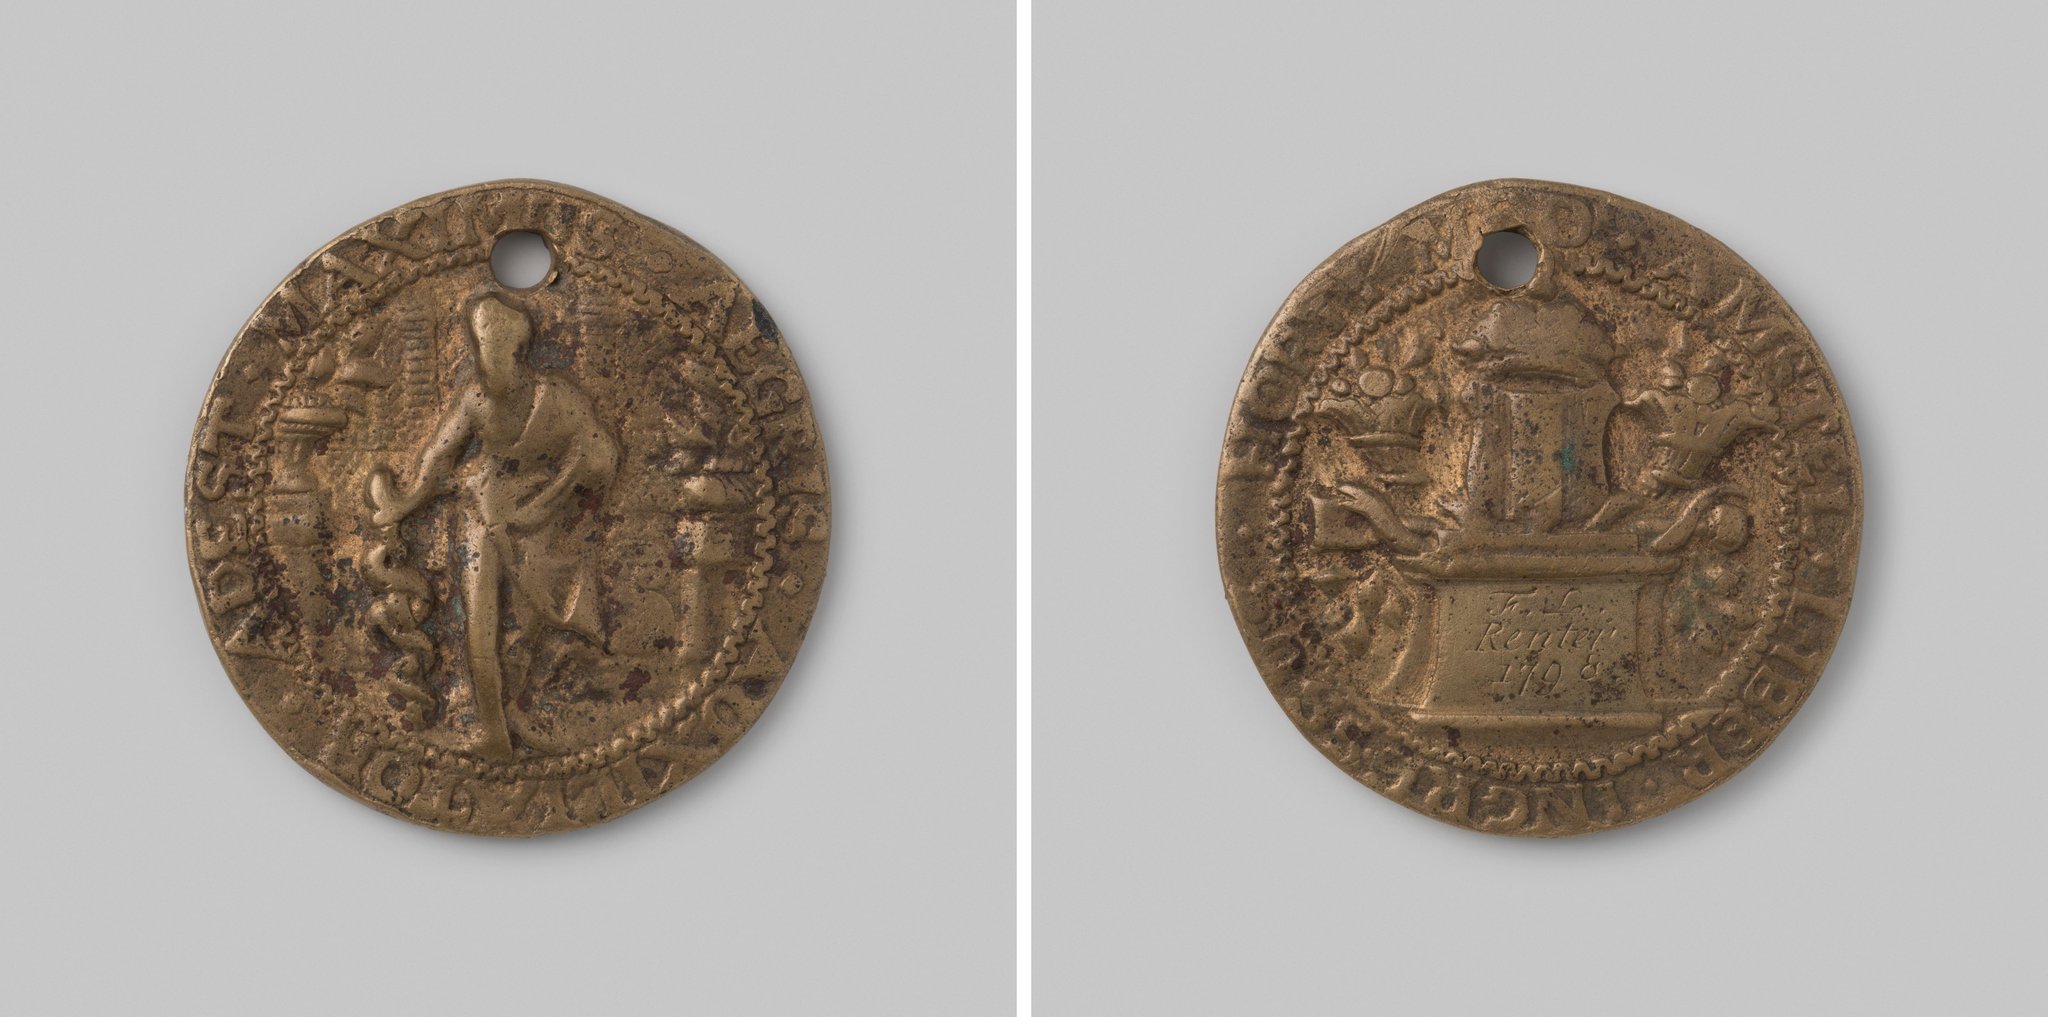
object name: medal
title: Toegangspenning tot de Hortus Medicus te Amsterdam 1696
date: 1696-1699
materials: brass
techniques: casting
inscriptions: circumscription: ‘MAXIMUS AEGRIS AUXILIATOR ADEST’, circumscription: ‘HORTI MED AMSTEL LIBER INGRESSUS’, inscription: ‘F.L. / Renter / 1798’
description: Gegoten koperen penning met op de voorzijde Aesculapius en op de keerzijde een altaar waarop het gekroonde stadswapen, een caduceus en cornucopiae waaruit kruidentakken, op naam van F.L. Renter 1798